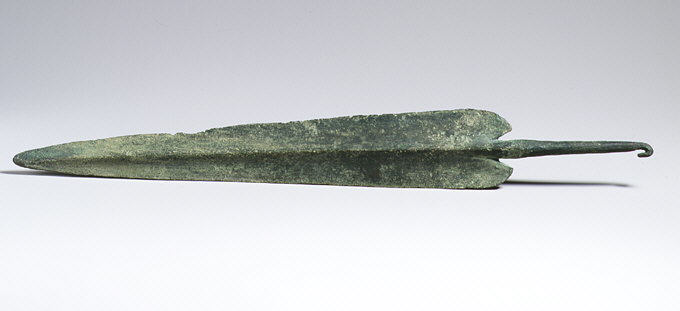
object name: dagger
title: Copper alloy spearhead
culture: cypriot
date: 2500-2000 BCE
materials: bronze